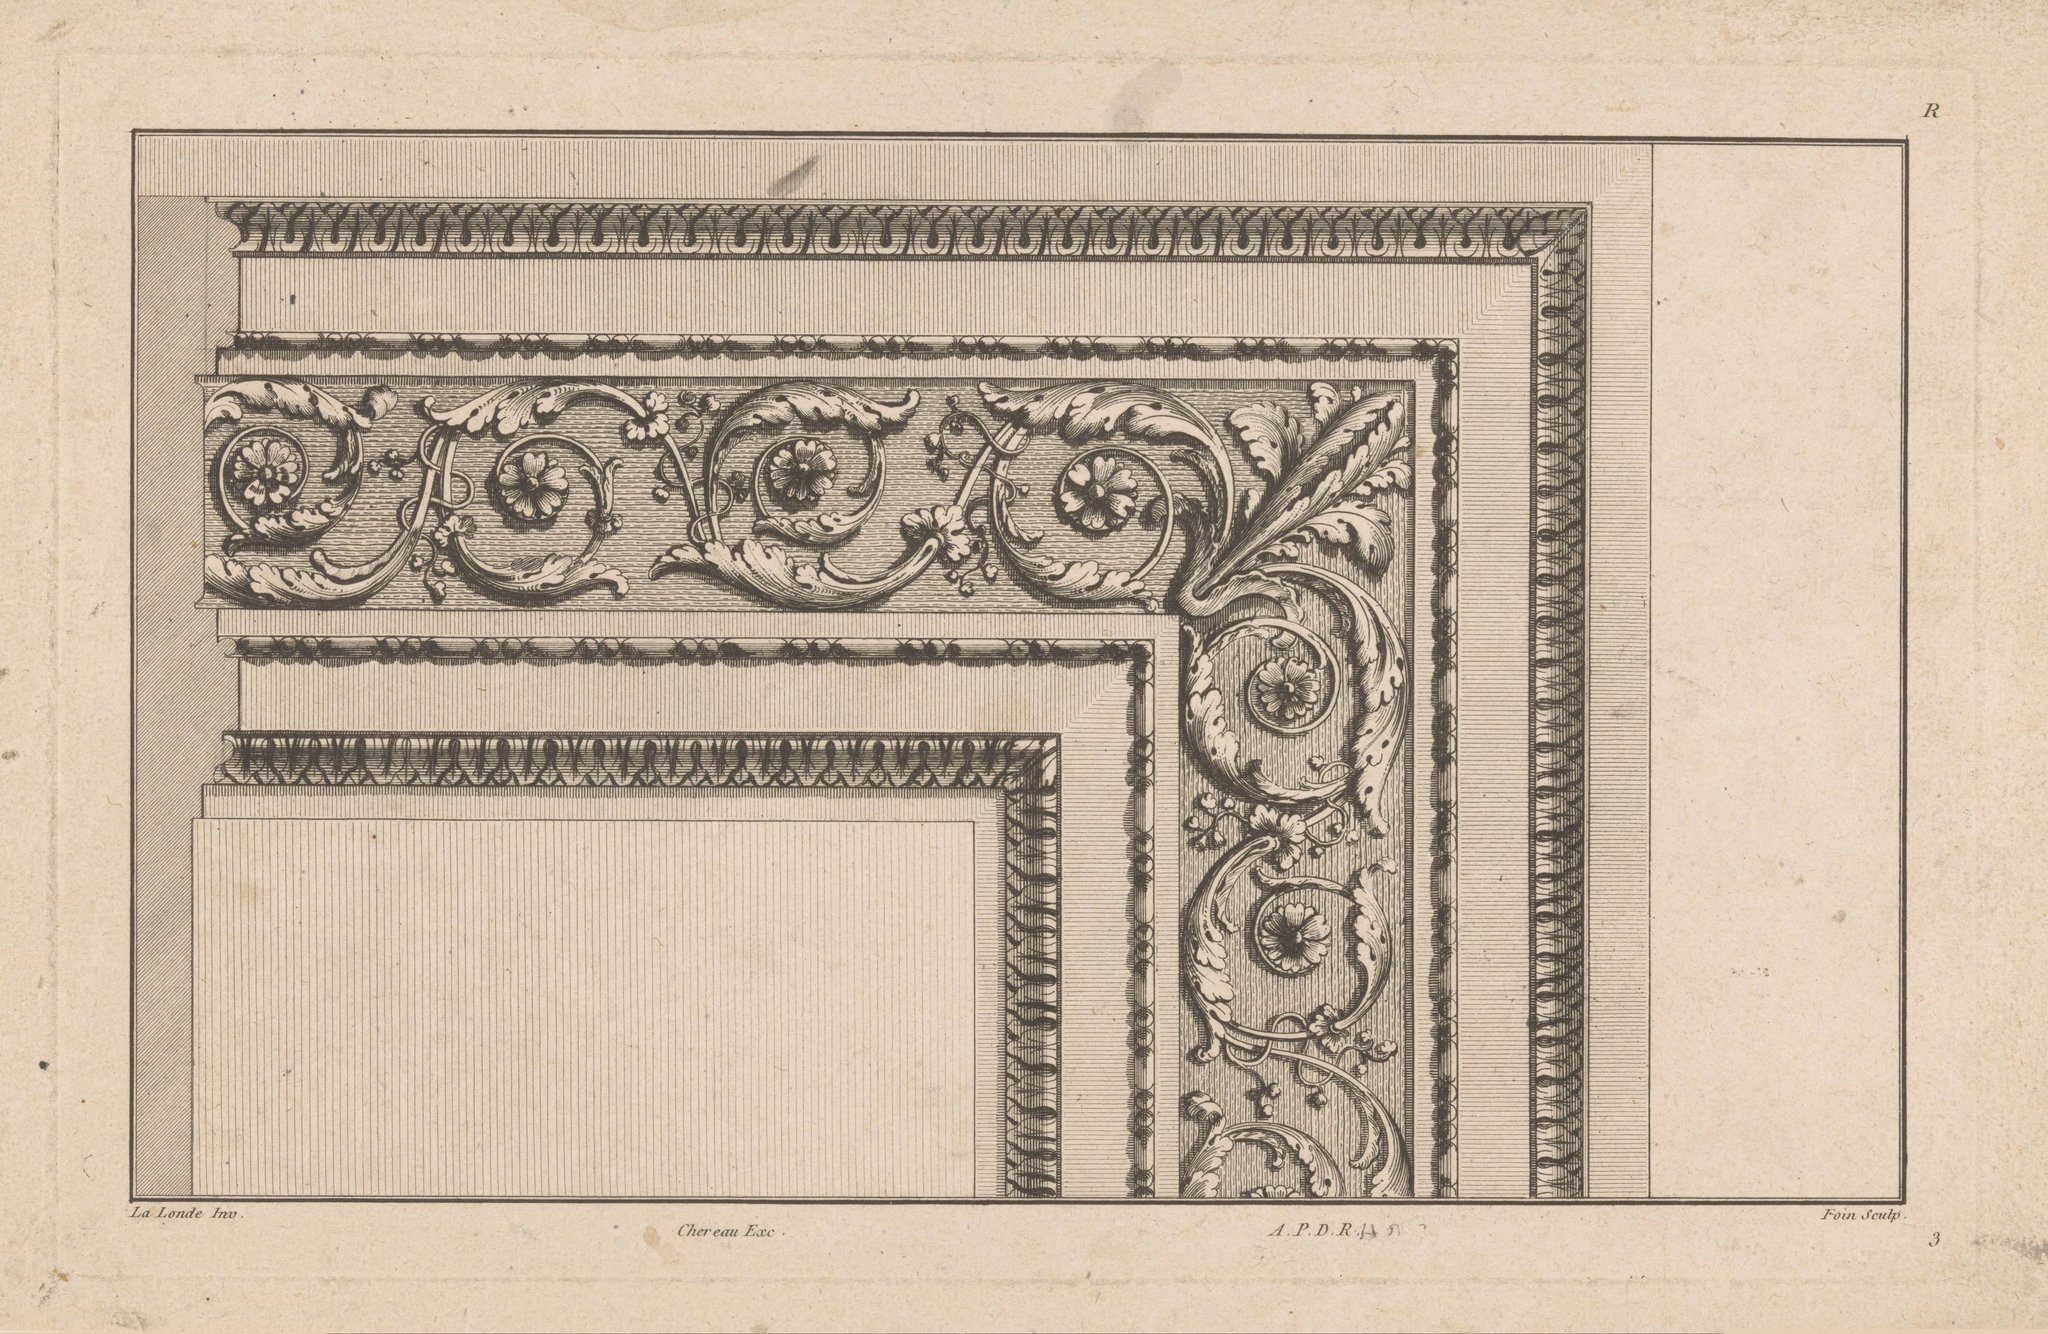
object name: ornament print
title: R Cahier de Bordures et de Corniches d'Appartement (...)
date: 1784-1785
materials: paper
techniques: engraving, etching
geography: paris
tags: interlace ~ ornament, ornaments ~ art (+ framing decorations)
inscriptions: collector's mark: Lugt 2760, collector's mark: Lugt 2228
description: Een geornamenteerde lijst met vlechtwerk en bladmotieven.